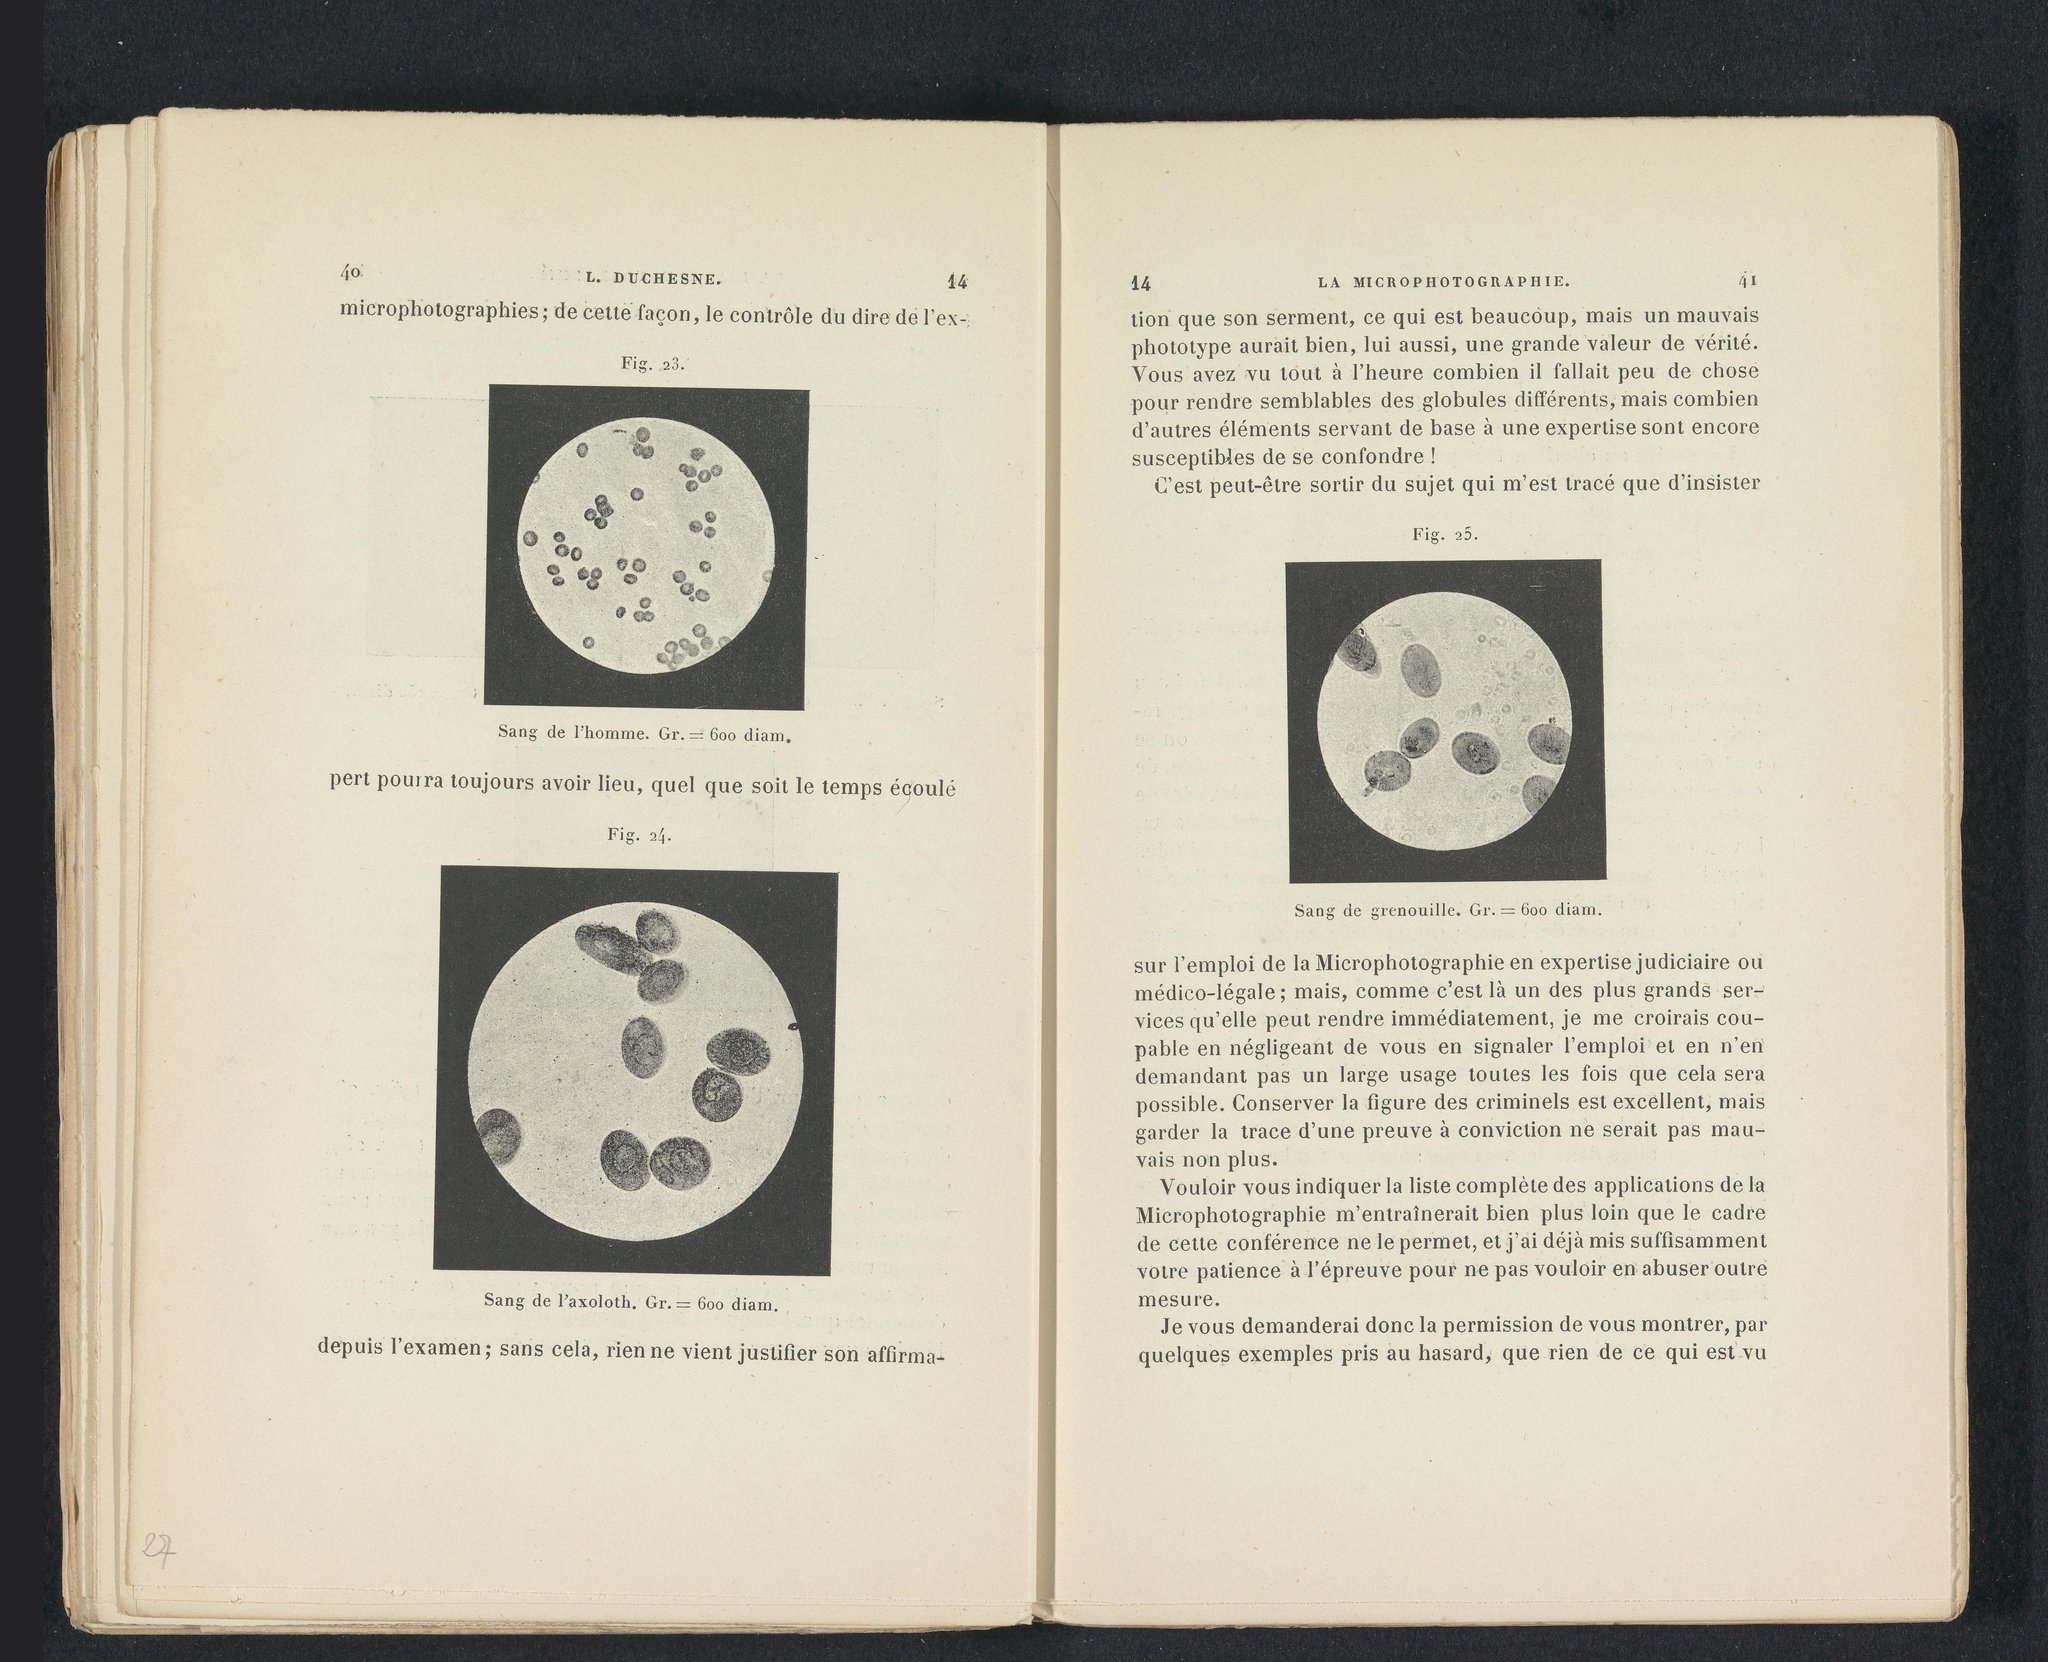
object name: page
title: Vergroting van het bloed van een kikker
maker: Anonymous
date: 1883-1893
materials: paper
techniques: autotype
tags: tailless amphibians: frog, blood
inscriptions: number: ‘Fig. 25.’, inscription: ‘Sang de grenouille. Gr. = 600 diam.’